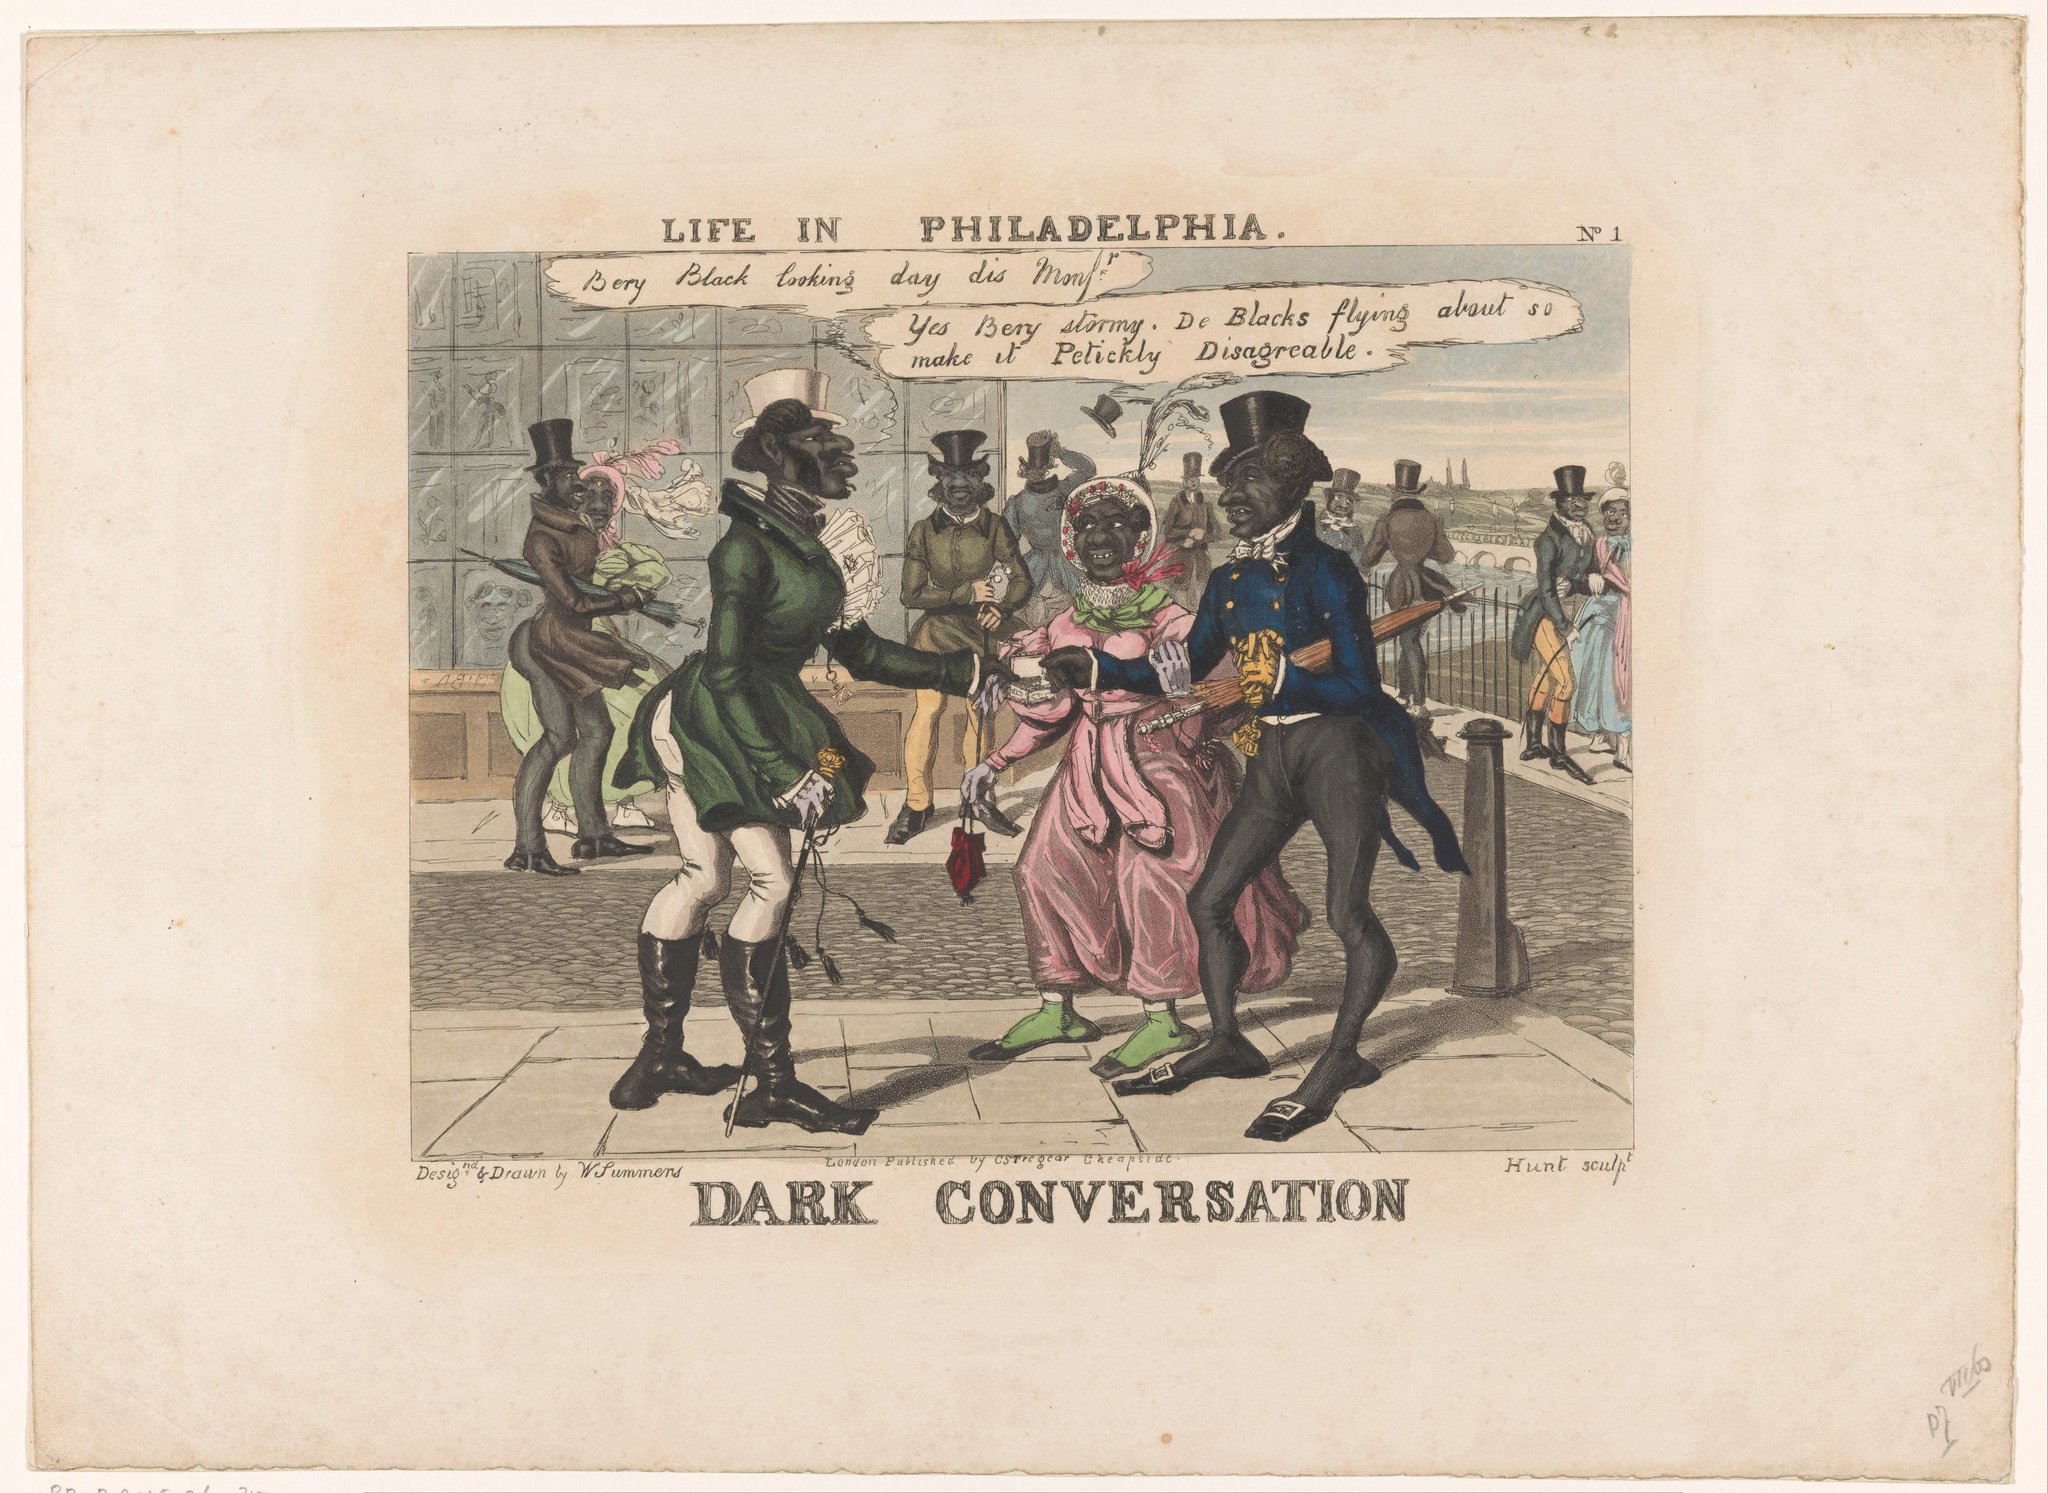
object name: print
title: Spotprent op zwarte inwoners van Philadelphia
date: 1834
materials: paper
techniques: aquatint, etching, hand coloring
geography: london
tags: caricatures (human types), americans with african roots, african-americans (+ caricatured), city-view in general; 'veduta' (+ city(-scape) with figures, staffage), shop-window, show-window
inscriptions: collector's mark: Lugt 2228, collector's mark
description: Uit een serie spotprenten uitgeven onder de titel: Black Jokes, being a series of laughable caricatures on the march of manners amongst blacks, geïnspireerd op de serie Life in Philadelphia, bestaande uit 14 prenten door Edward W. Clay, uitgegeven in 1828-1830. Zie het artikel van Radiclani Clytus in: Black Victorians: Black People in British Art 1800-1900.